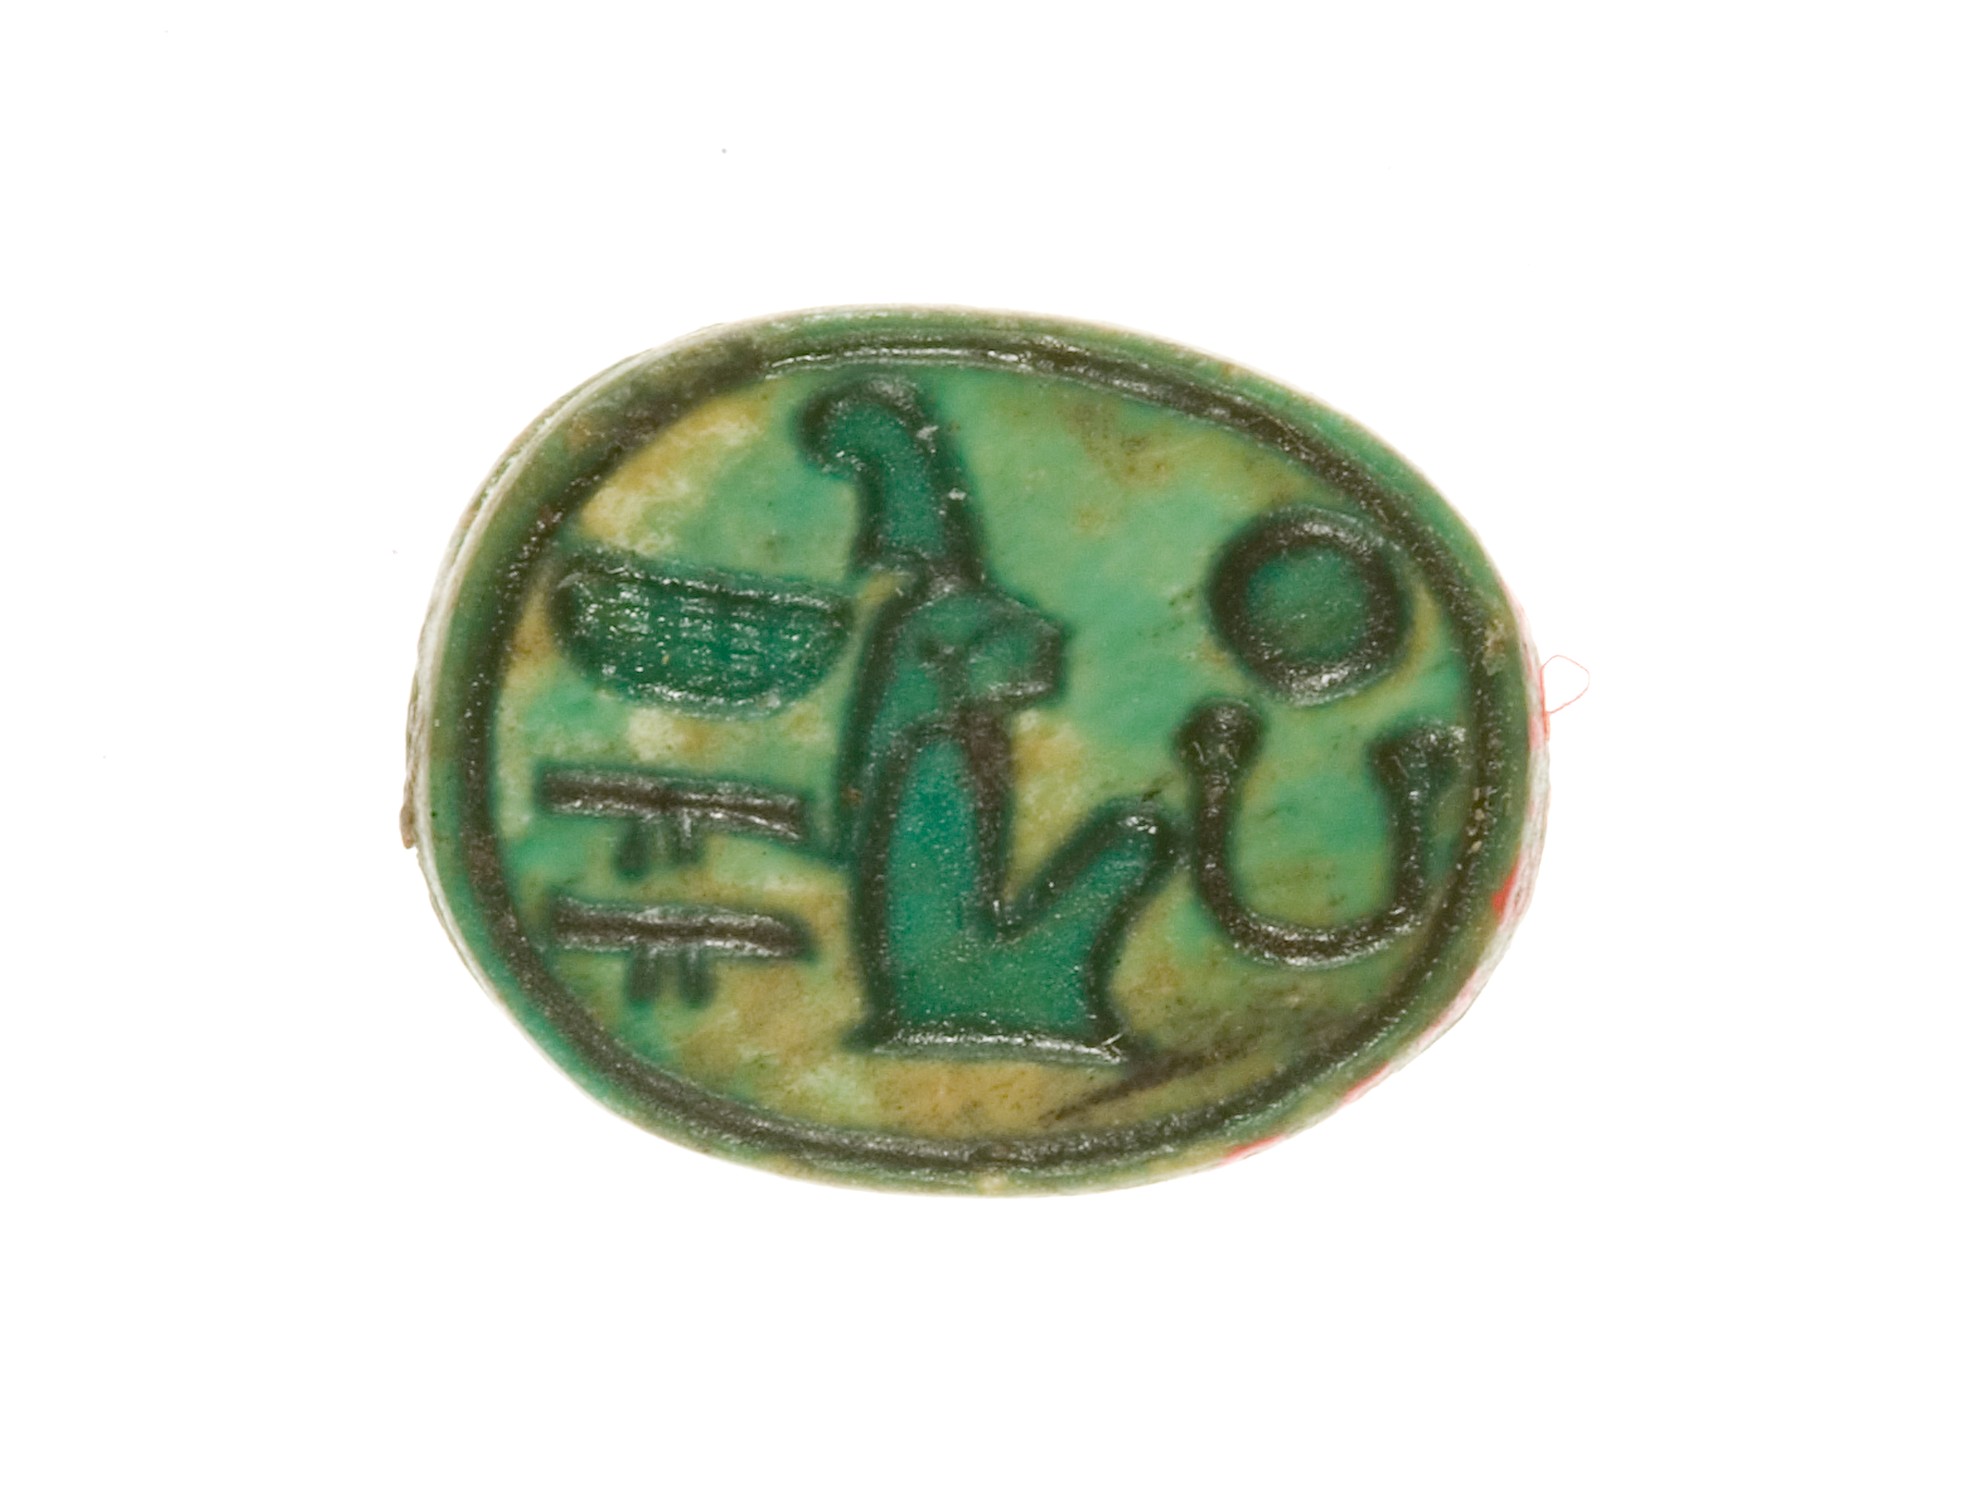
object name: scarab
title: Scarab Inscribed for Maatkare (Hatshepsut), Lord of the Two Lands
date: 1479-1458 BCE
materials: stone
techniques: glazing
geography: egypt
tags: hieroglyphs,scarabs